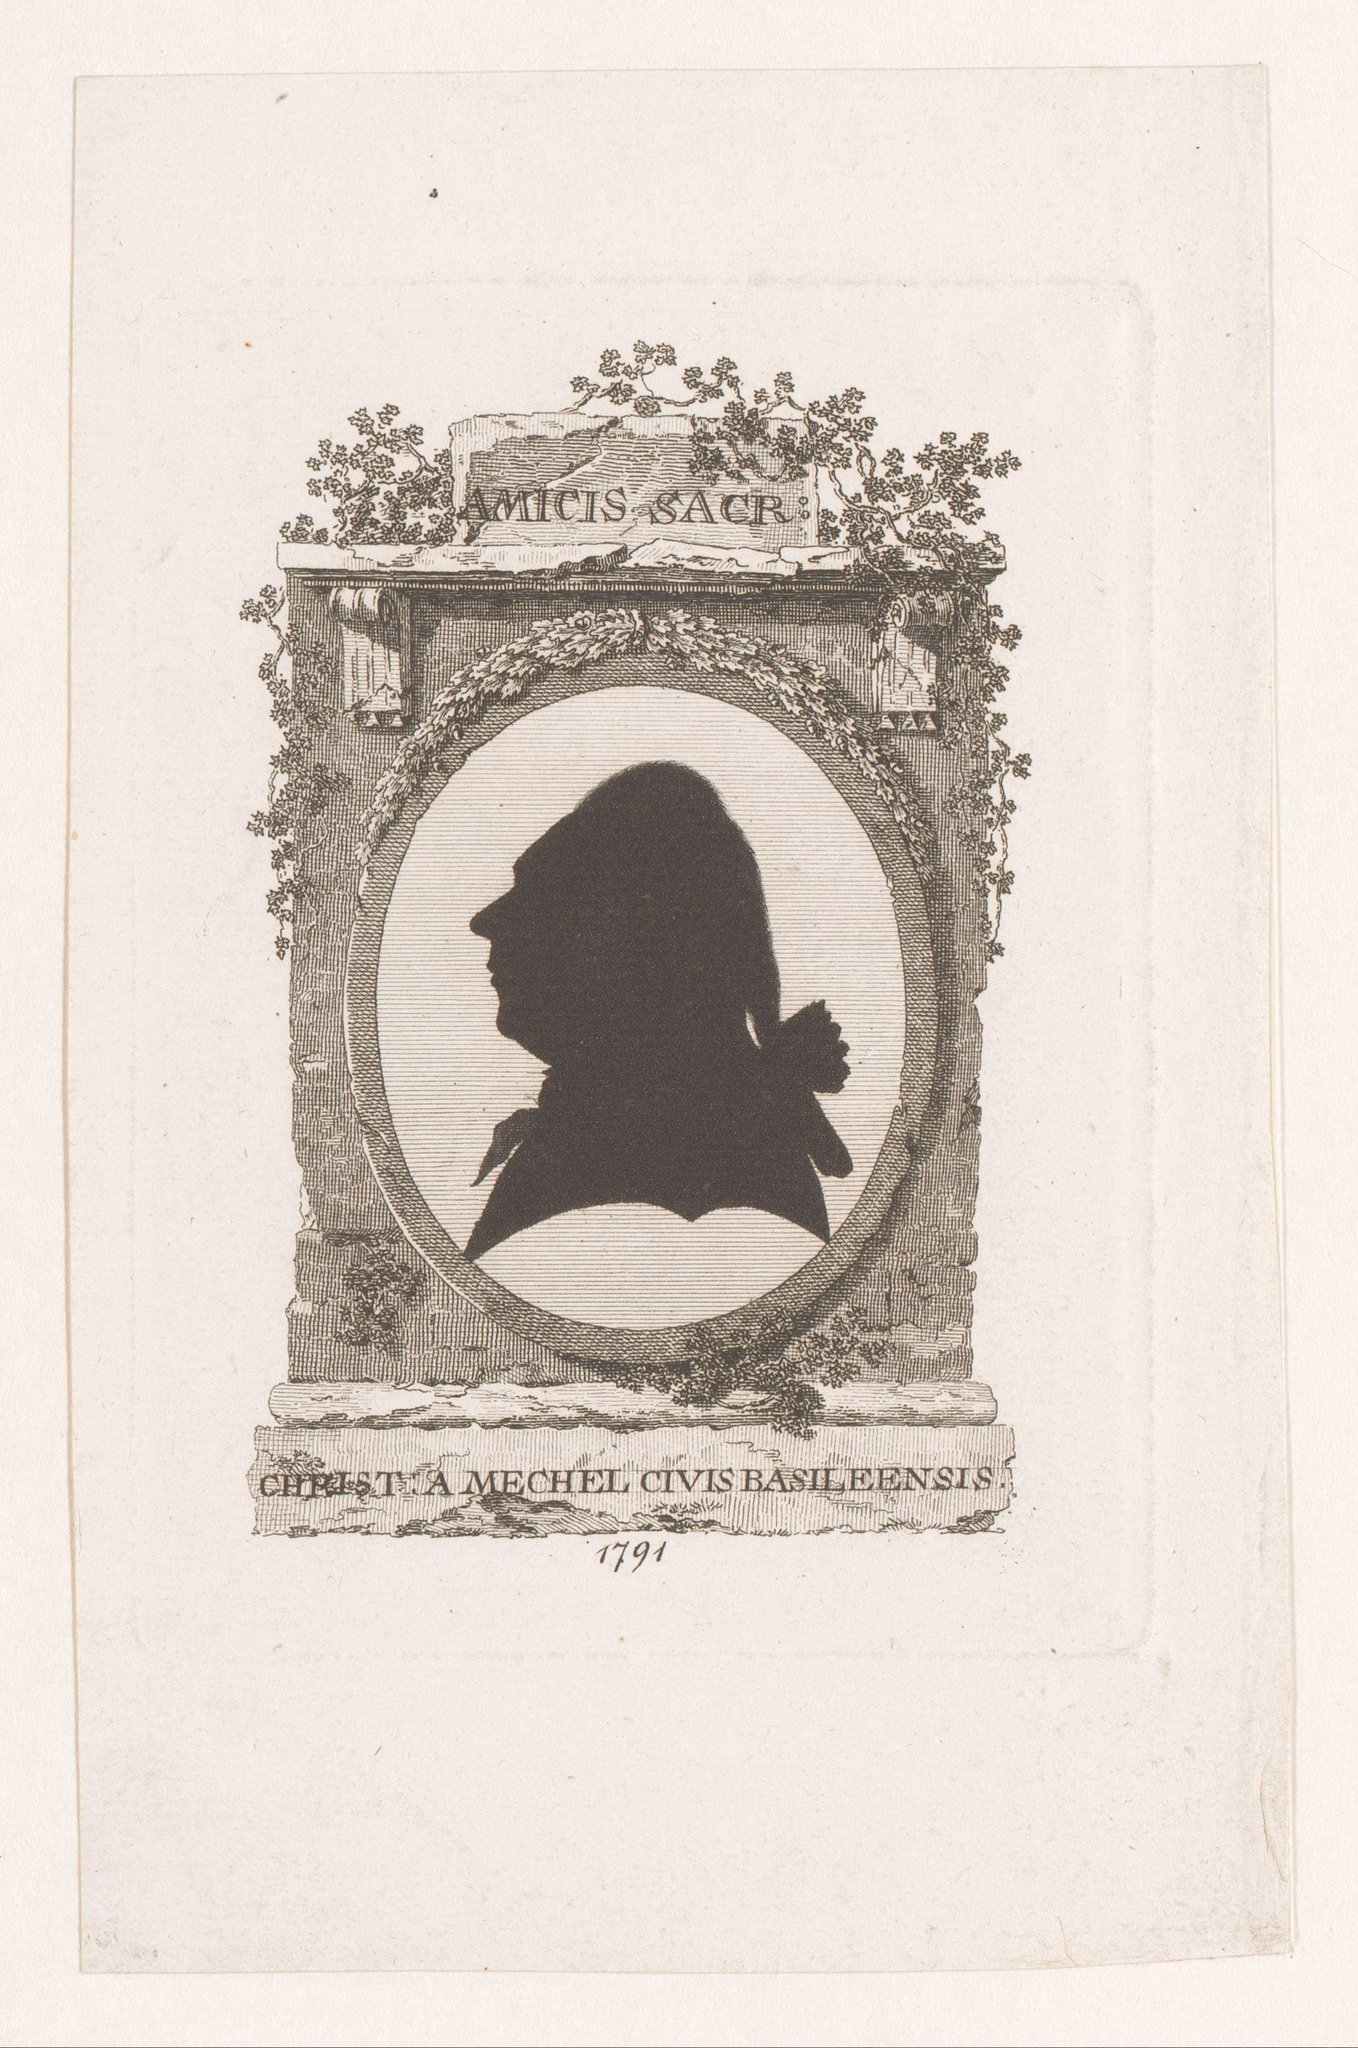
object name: print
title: Zelfportret in silhouet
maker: christian von mechel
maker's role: draughtsman, print maker, publisher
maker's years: 1737-1817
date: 1791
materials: paper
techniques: etching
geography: basel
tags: berlin, print maker, draughtsman, publisher, christian von mechel, portrait, self-portrait of artist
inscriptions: collector's mark: Lugt 2228